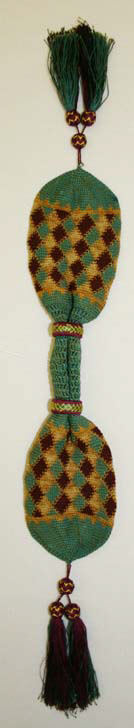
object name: miser's purse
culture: american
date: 1867-1900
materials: silk